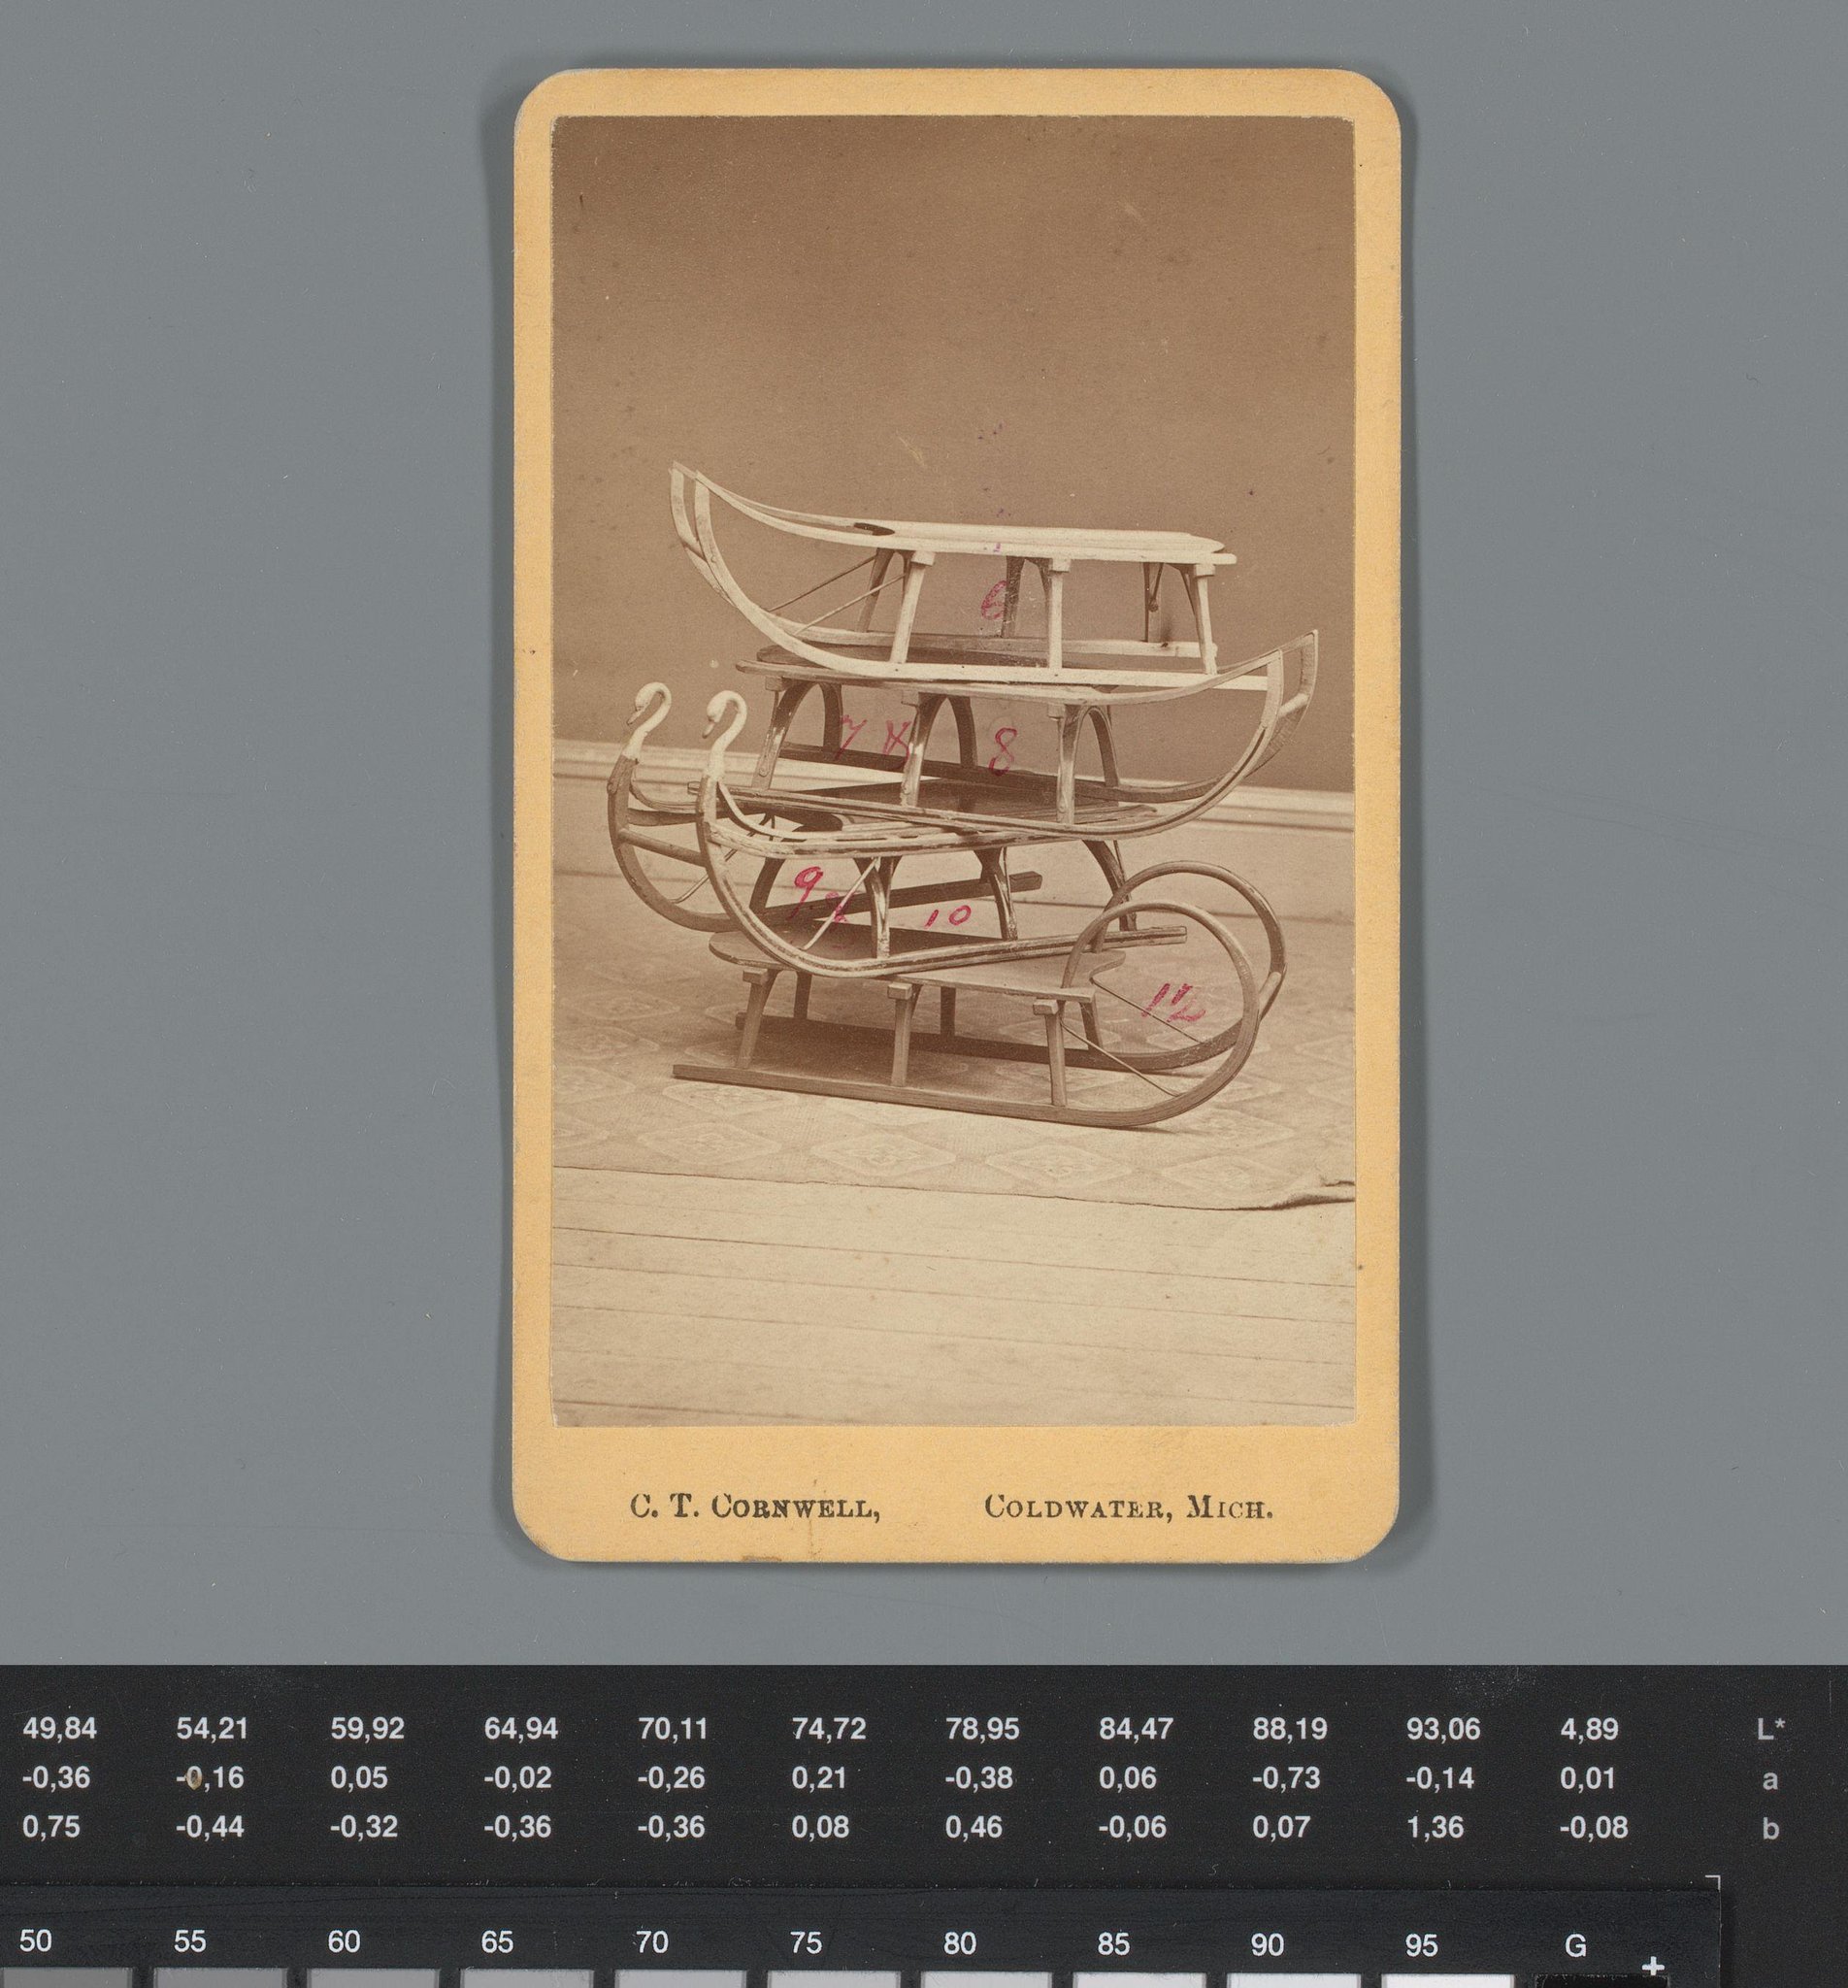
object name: photograph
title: Drie sleeën op elkaar gestapeld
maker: charles titus cornwell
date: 1860-1915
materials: cardboard, photographic support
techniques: albumen print, pen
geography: michigan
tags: sledge, sleigh (winter sports)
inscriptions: number: ‘6/ 7/ 8/ 9/ 10/ 12’